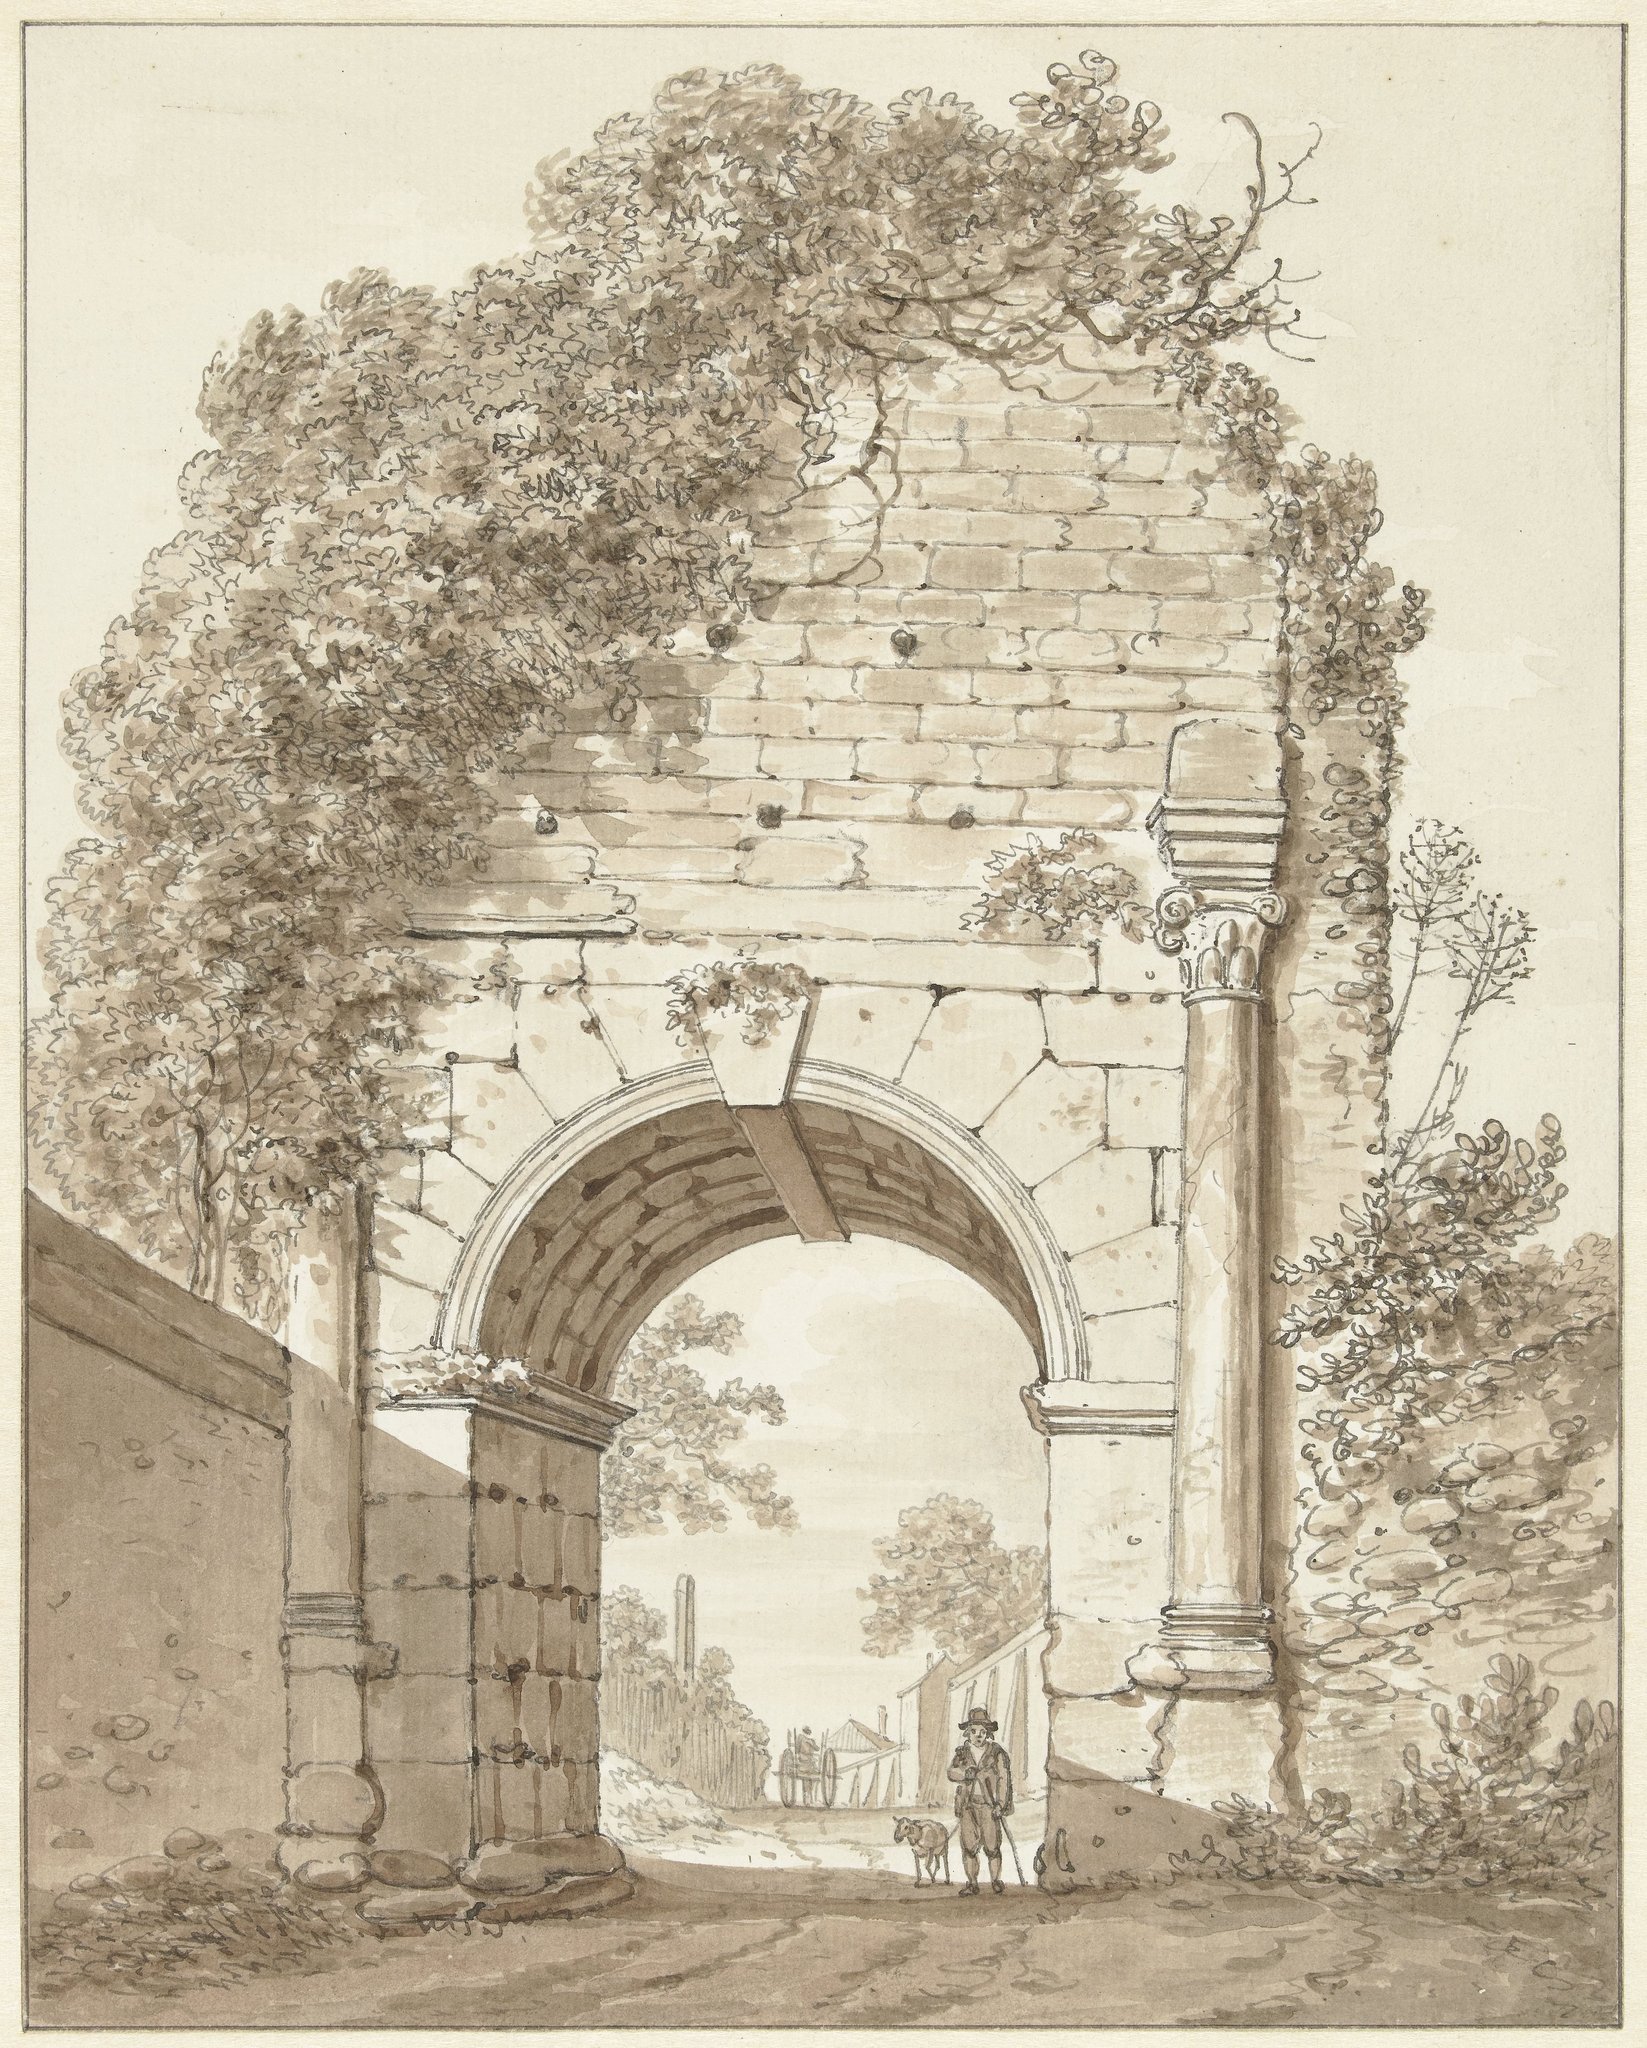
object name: drawing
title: Boog van Drusus te Rome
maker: daniël dupré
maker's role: draughtsman, print maker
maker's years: 1751-1817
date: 1789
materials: ink, paper, pencil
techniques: brush, pen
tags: triumphal arch, representation of real building (either existing or having existed) (+ roman art), italy, rome